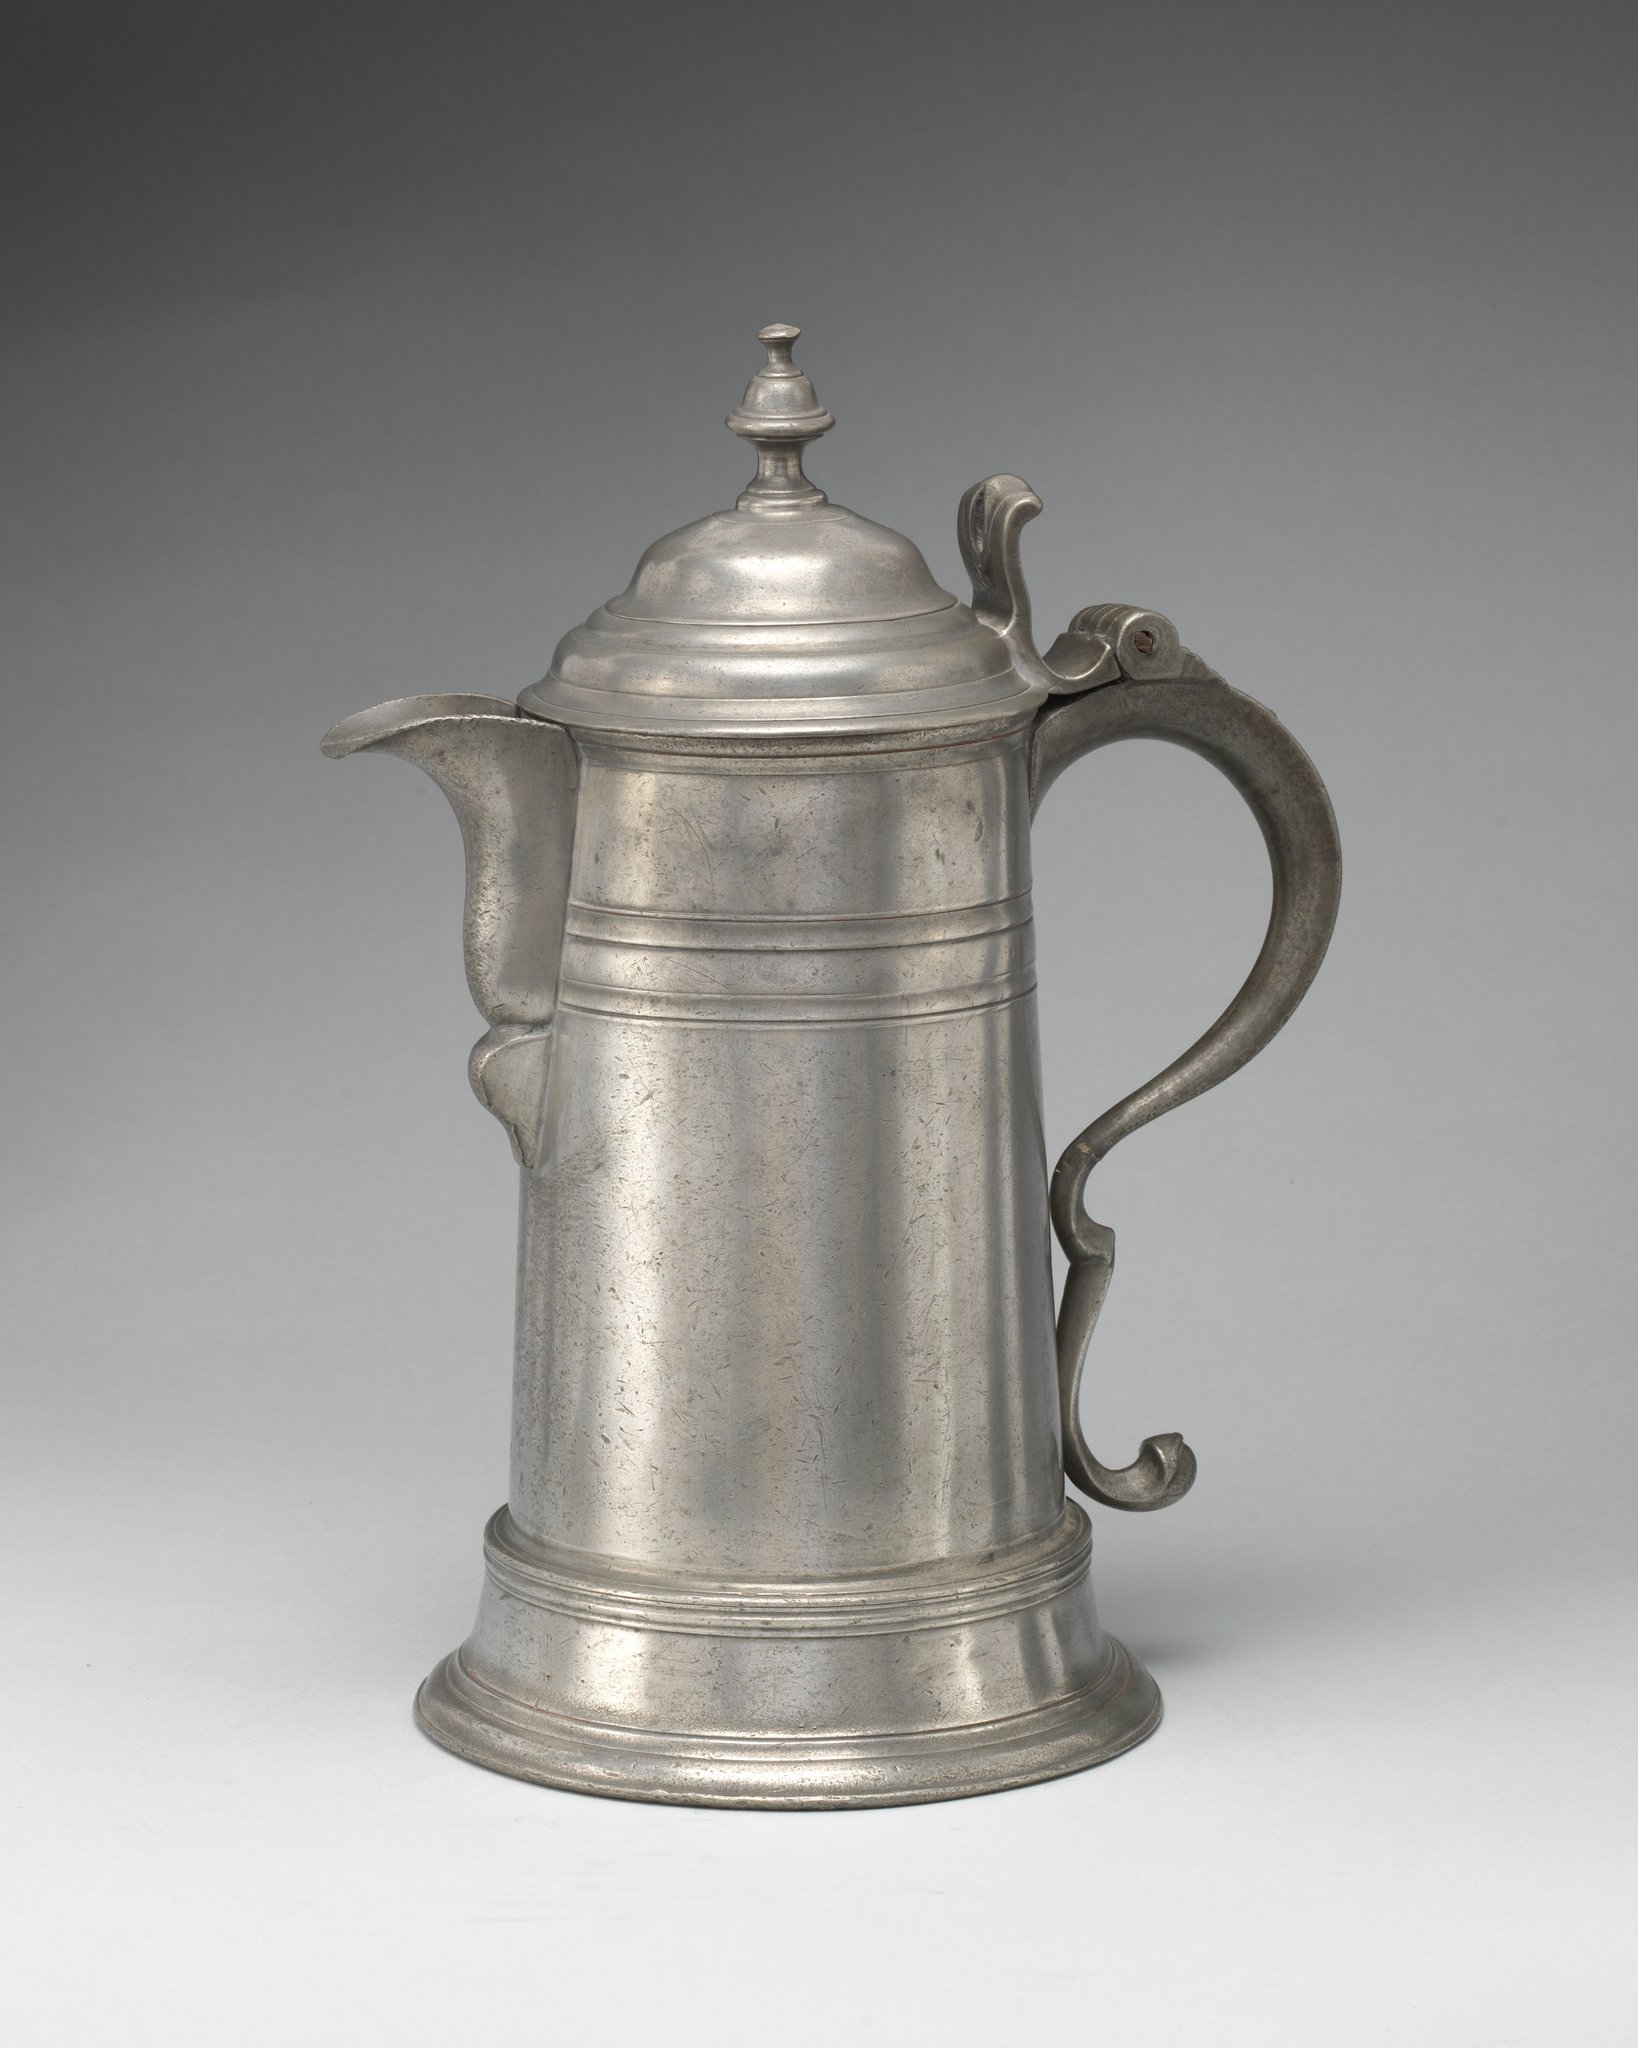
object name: church flagon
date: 1701-1800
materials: pewter